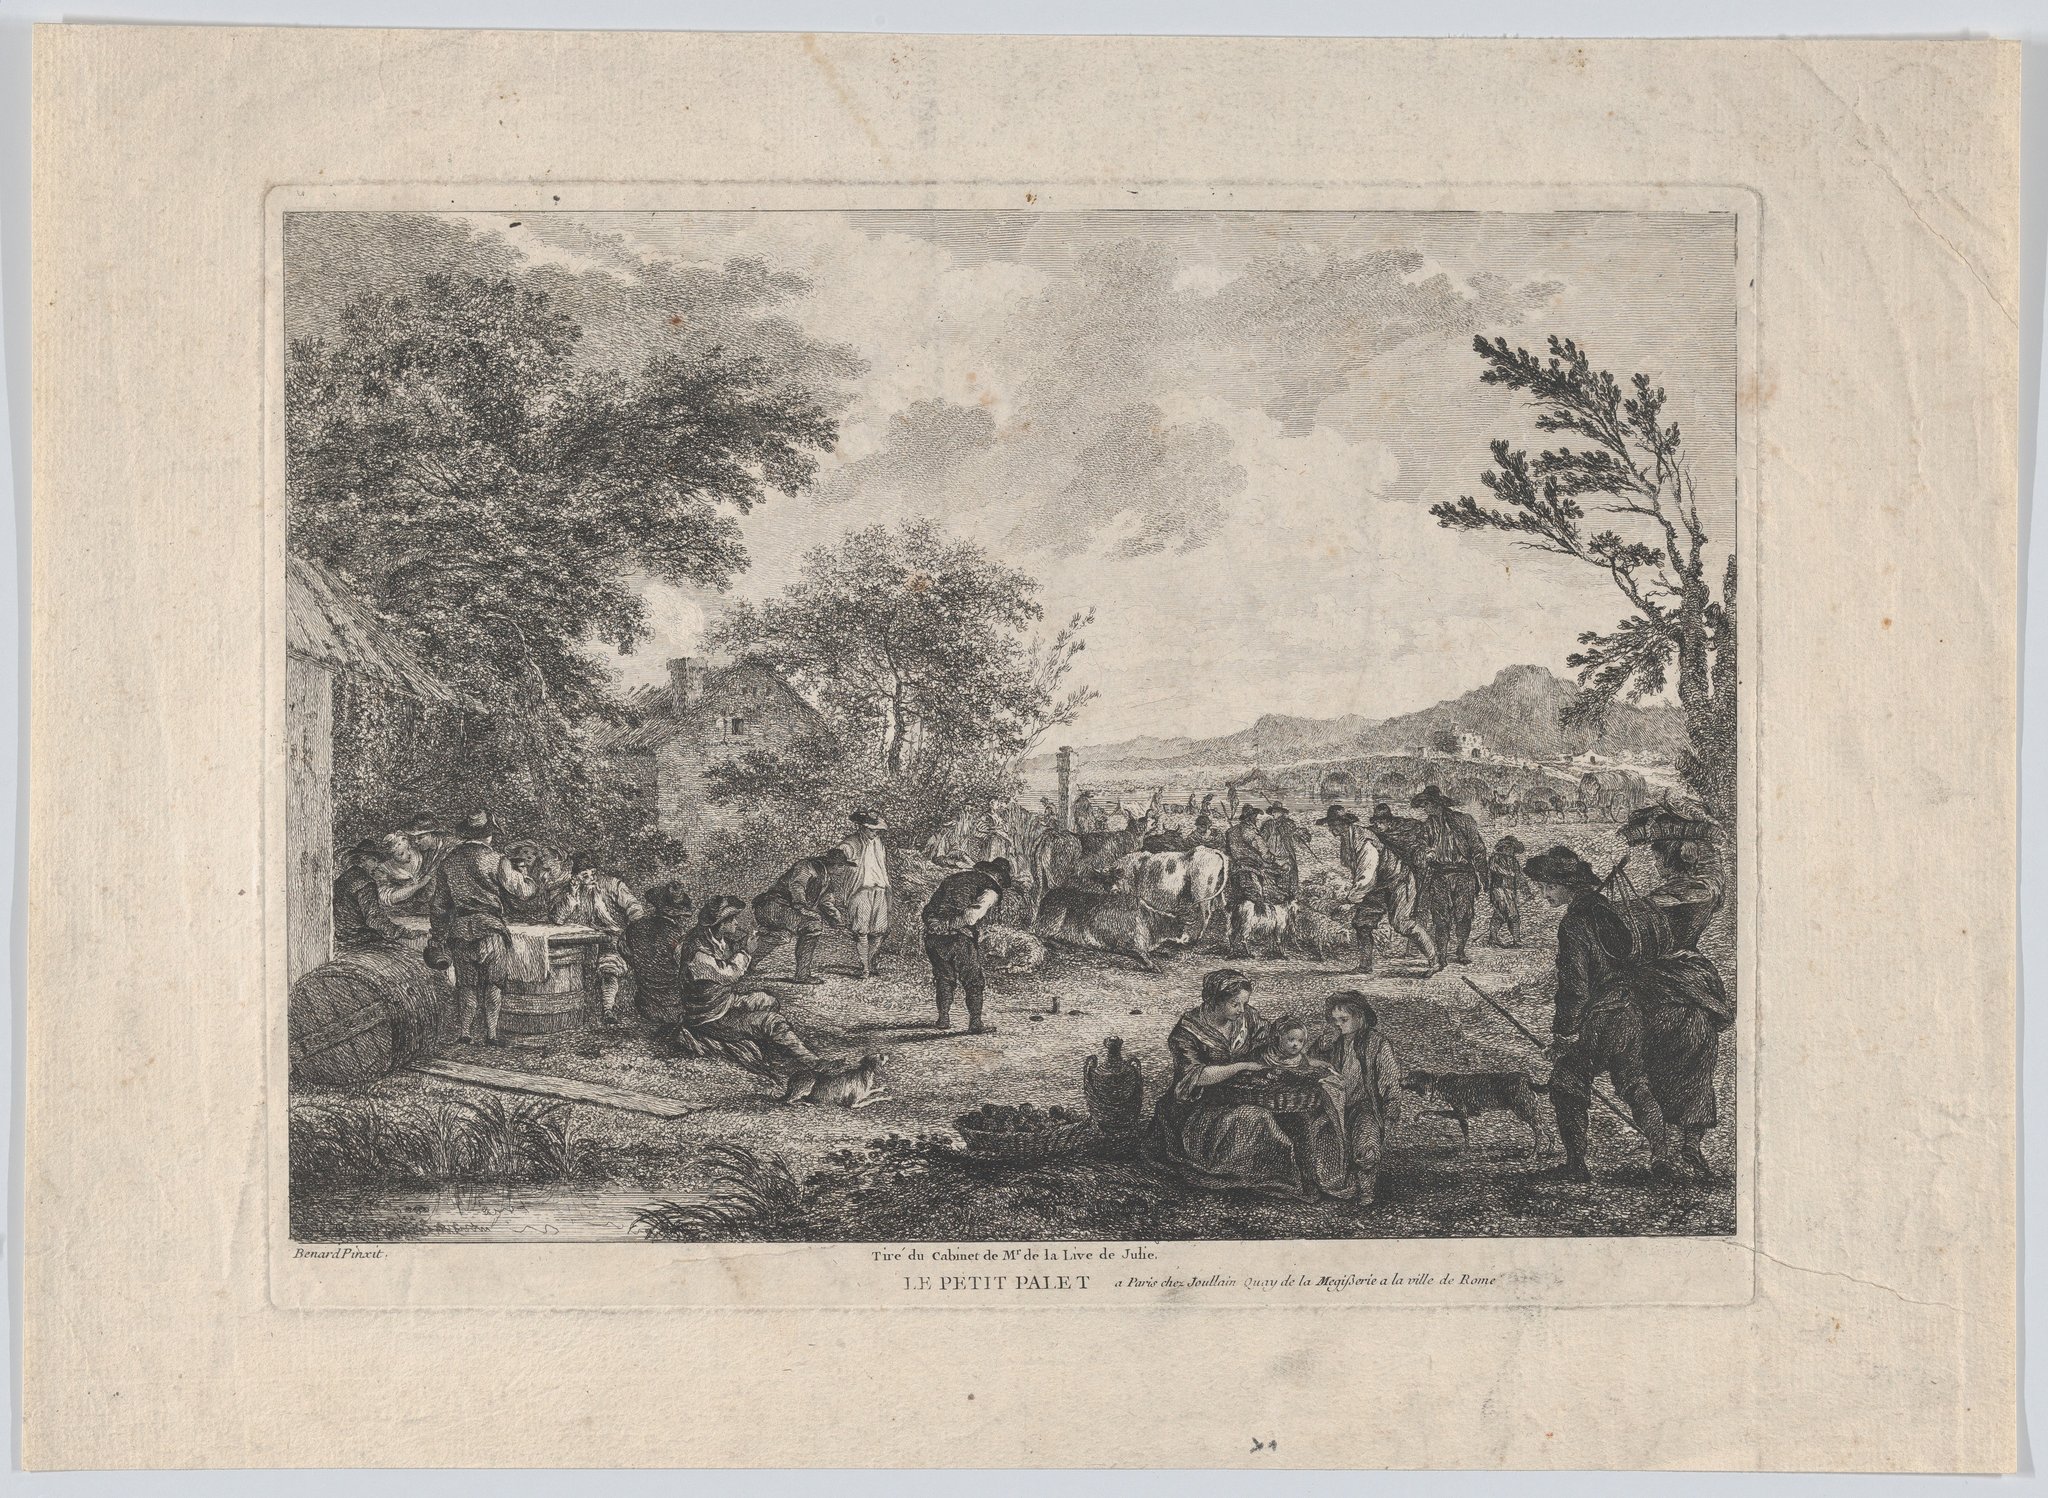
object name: print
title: The Little Puck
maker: Anonymous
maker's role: artist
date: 1701-1800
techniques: engraving, etching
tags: landscapes,crowd